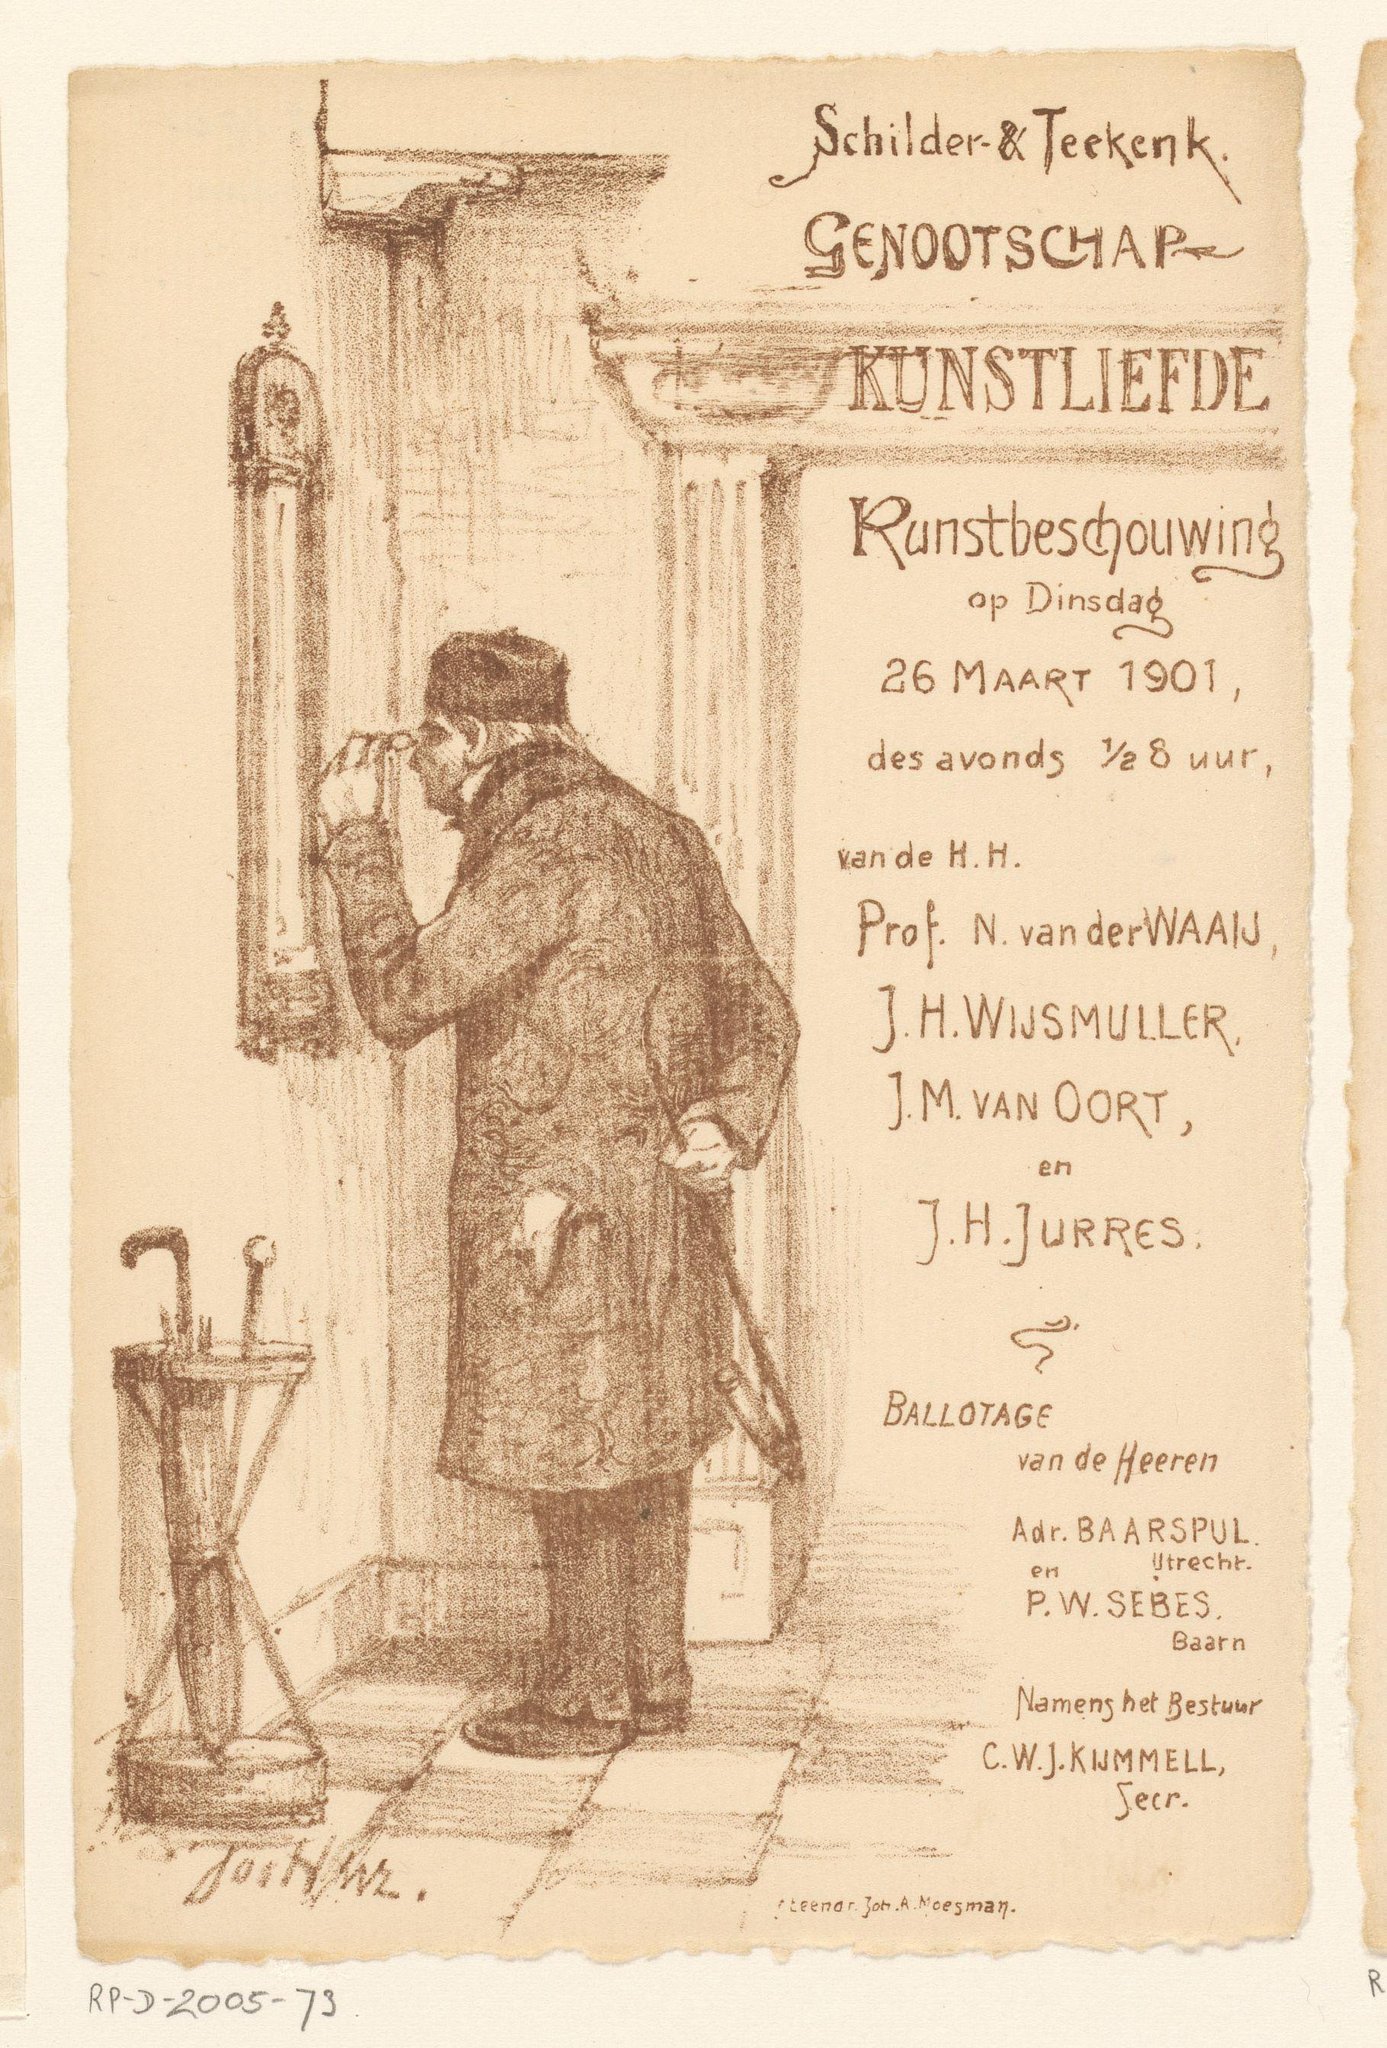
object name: invitation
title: Uitnodiging van Schilder- en Teekenkundig Genootschap "Kunstliefde" voor een kunstbeschouwing, 26 maart 1901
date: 1901-1903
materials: paper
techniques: lithograph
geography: netherlands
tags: nicolaas van der waay, amsterdam, painter, print maker, jan hillebrand wijsmuller, johannes hendricus jurres, draughtsman, jan van oort, criticizing and discussing art, art criticism, circle, club of artists, collecting and exhibiting products of the fine arts, pipe ~ tobacco, barometer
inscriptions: collector's mark: Lugt 2228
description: Een man raadpleegt een barometer, pijp in de hand. Uitnodiging van Schilder- en Teekenkundig Genootschap "Kunstliefde" voor een kunstbeschouwing op 26 maart 1901 van werk van N. van der Waay, J.H. Wijsmüller, J.M. van Oort en J.H. Jurres.